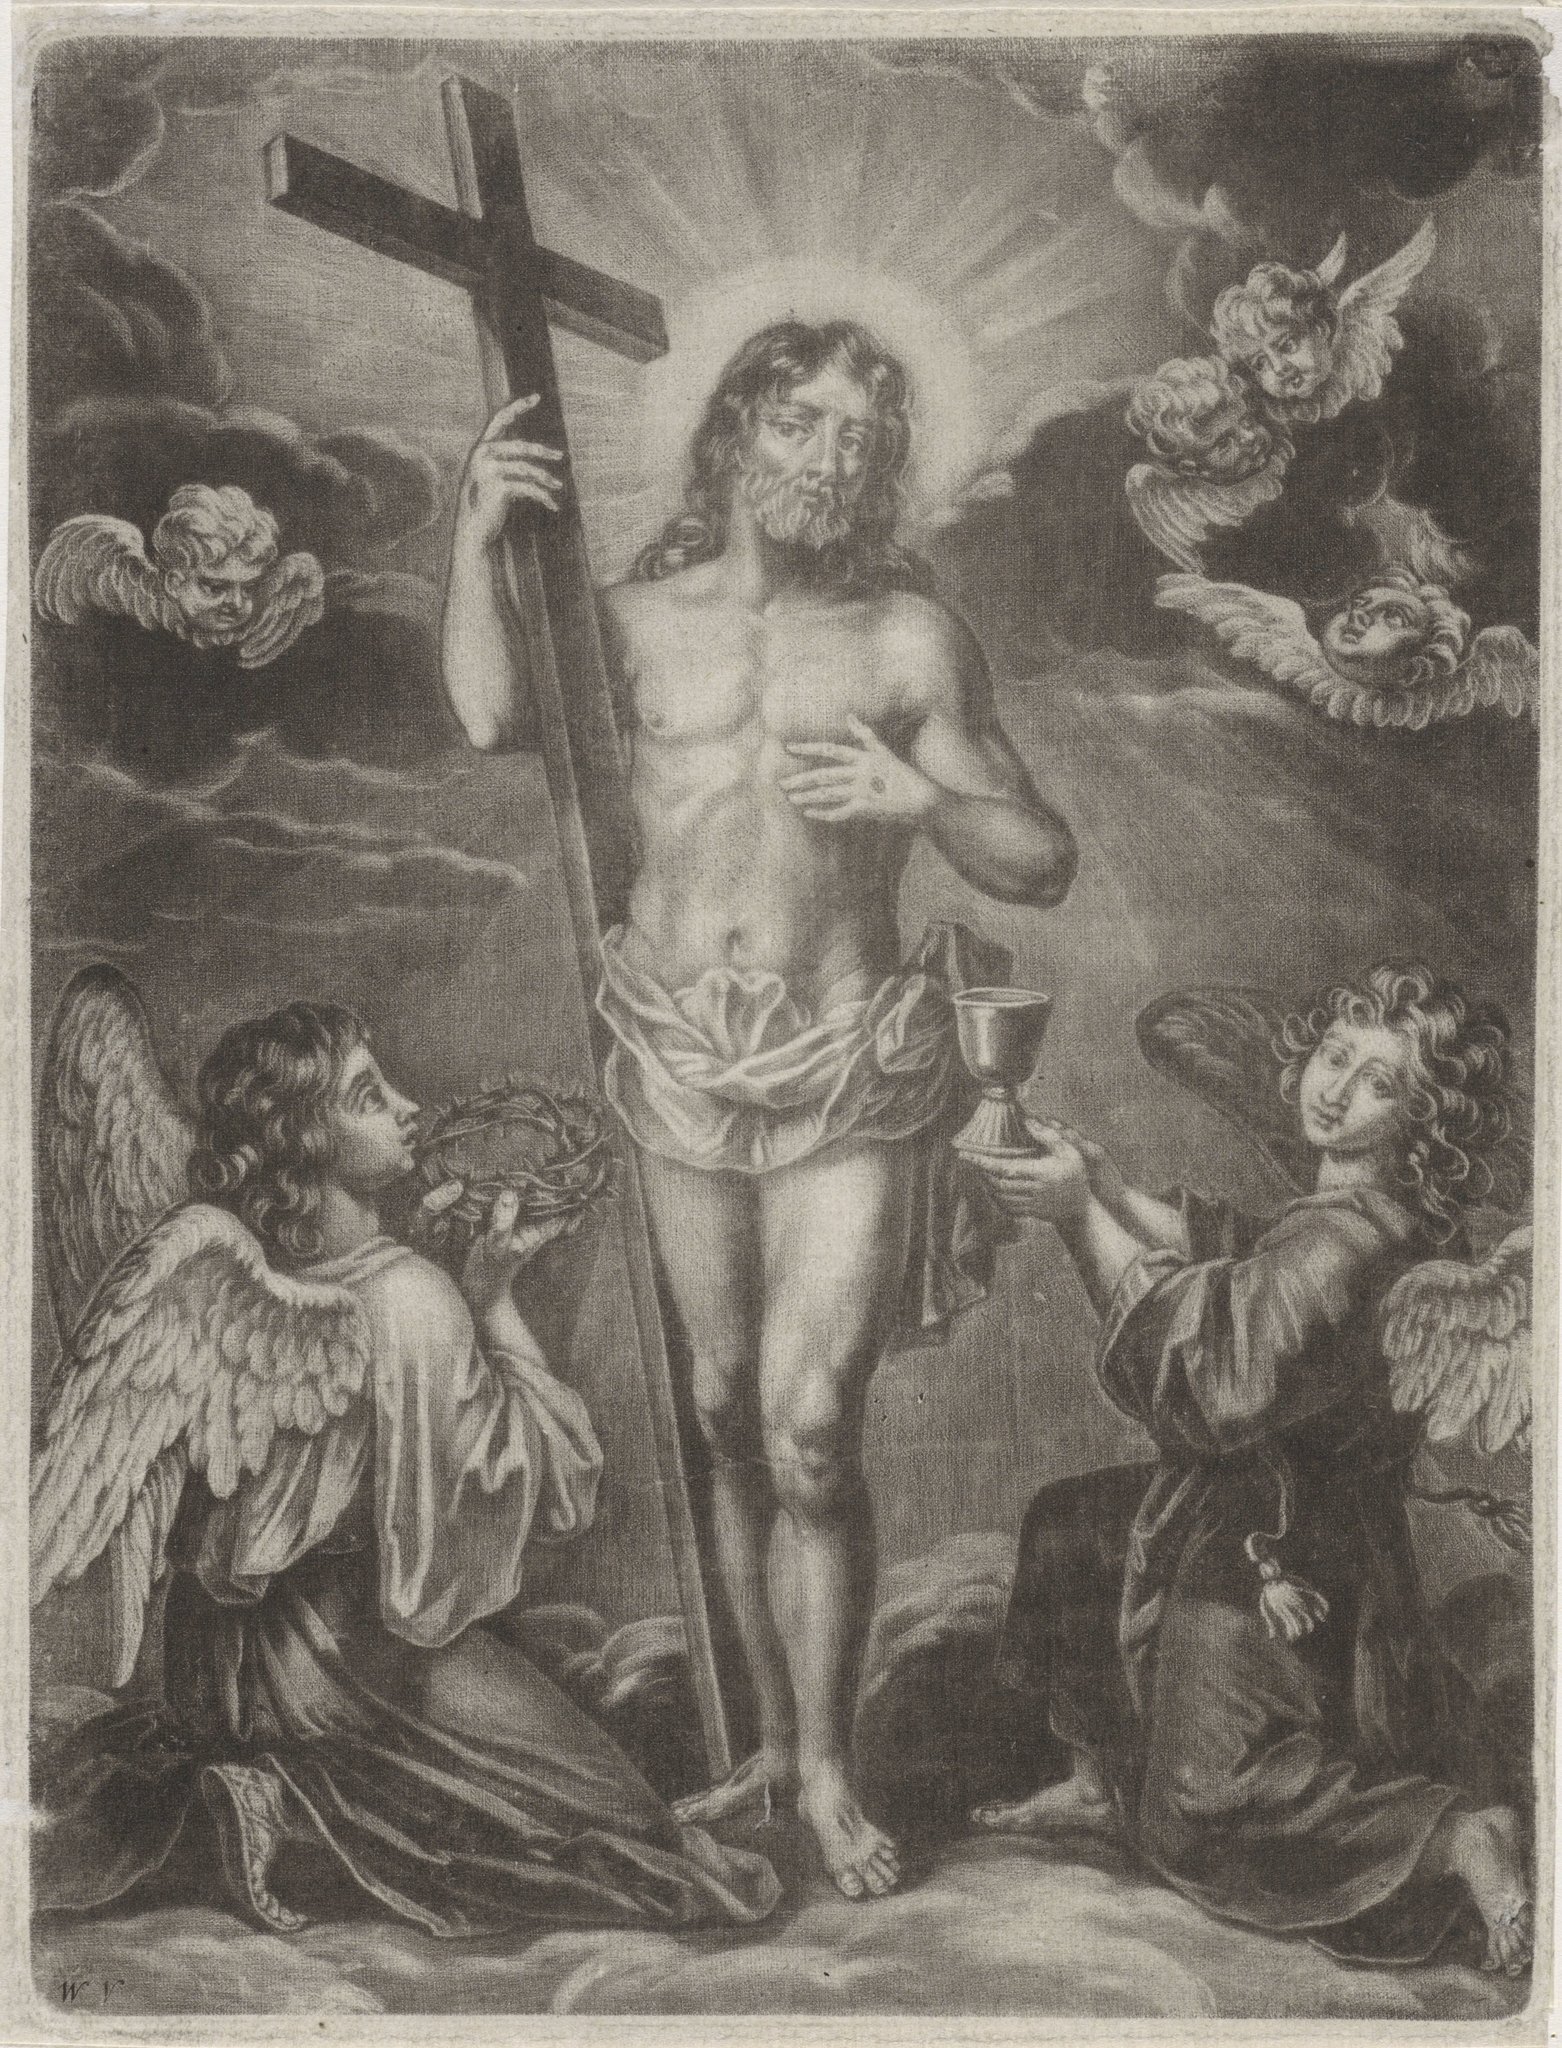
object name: print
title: Triomferende Christus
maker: wallerant vaillant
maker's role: draughtsman, painter, print maker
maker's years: 1623-1677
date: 1658-1677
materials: paper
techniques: mezzotint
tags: adult christ together with angels, christ triumphing (with crown, head usually upright)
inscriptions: collector's mark: Lugt 2228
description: Christus staat met het kruis in de hand op een wolkenpartij. Voor hem twee geknielde engelen met de doornenkroon en de kelk. In de lucht cherubijnen.